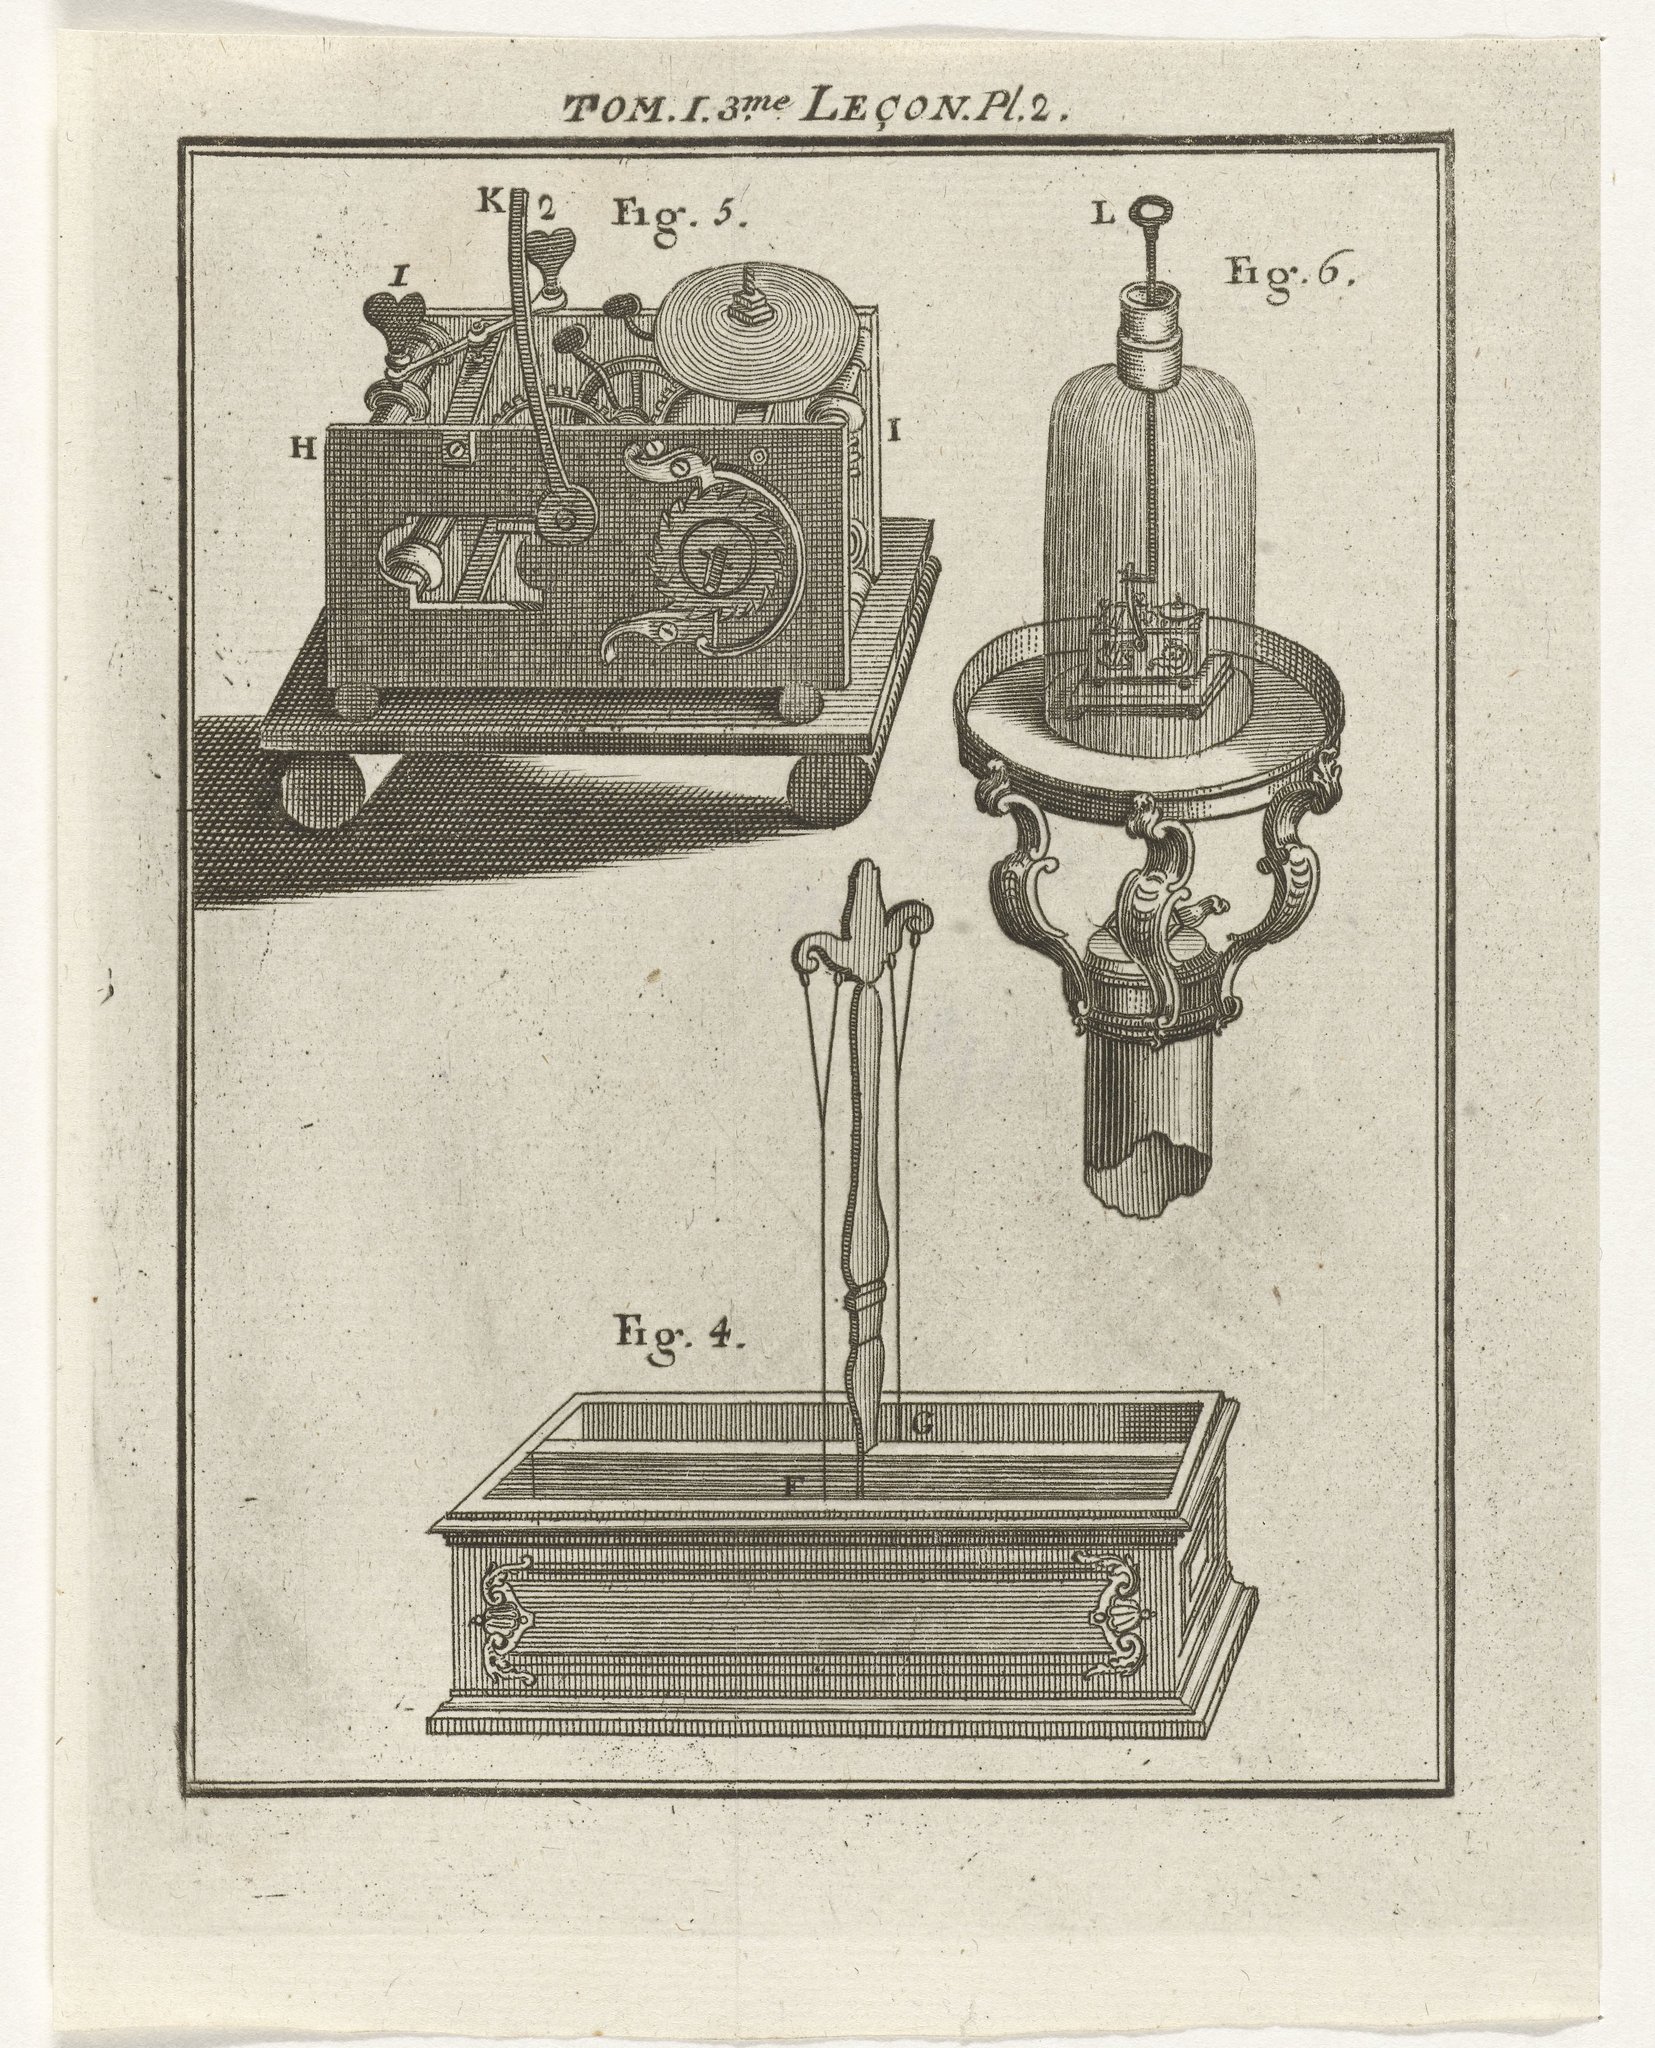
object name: print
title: Natuurkundige instrumenten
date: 1759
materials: paper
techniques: etching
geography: amsterdam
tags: physics (+ tools, instruments; laboratory equipment ~ scientific research)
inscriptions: collector's mark: Lugt 2228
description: Illustratie voor: Nollet, Jean Antoine. Natuurkundige lessen, door proefneemingen bevestigd, eerste deel. Amsterdam: Kornelis van Tongerlo, 1759.